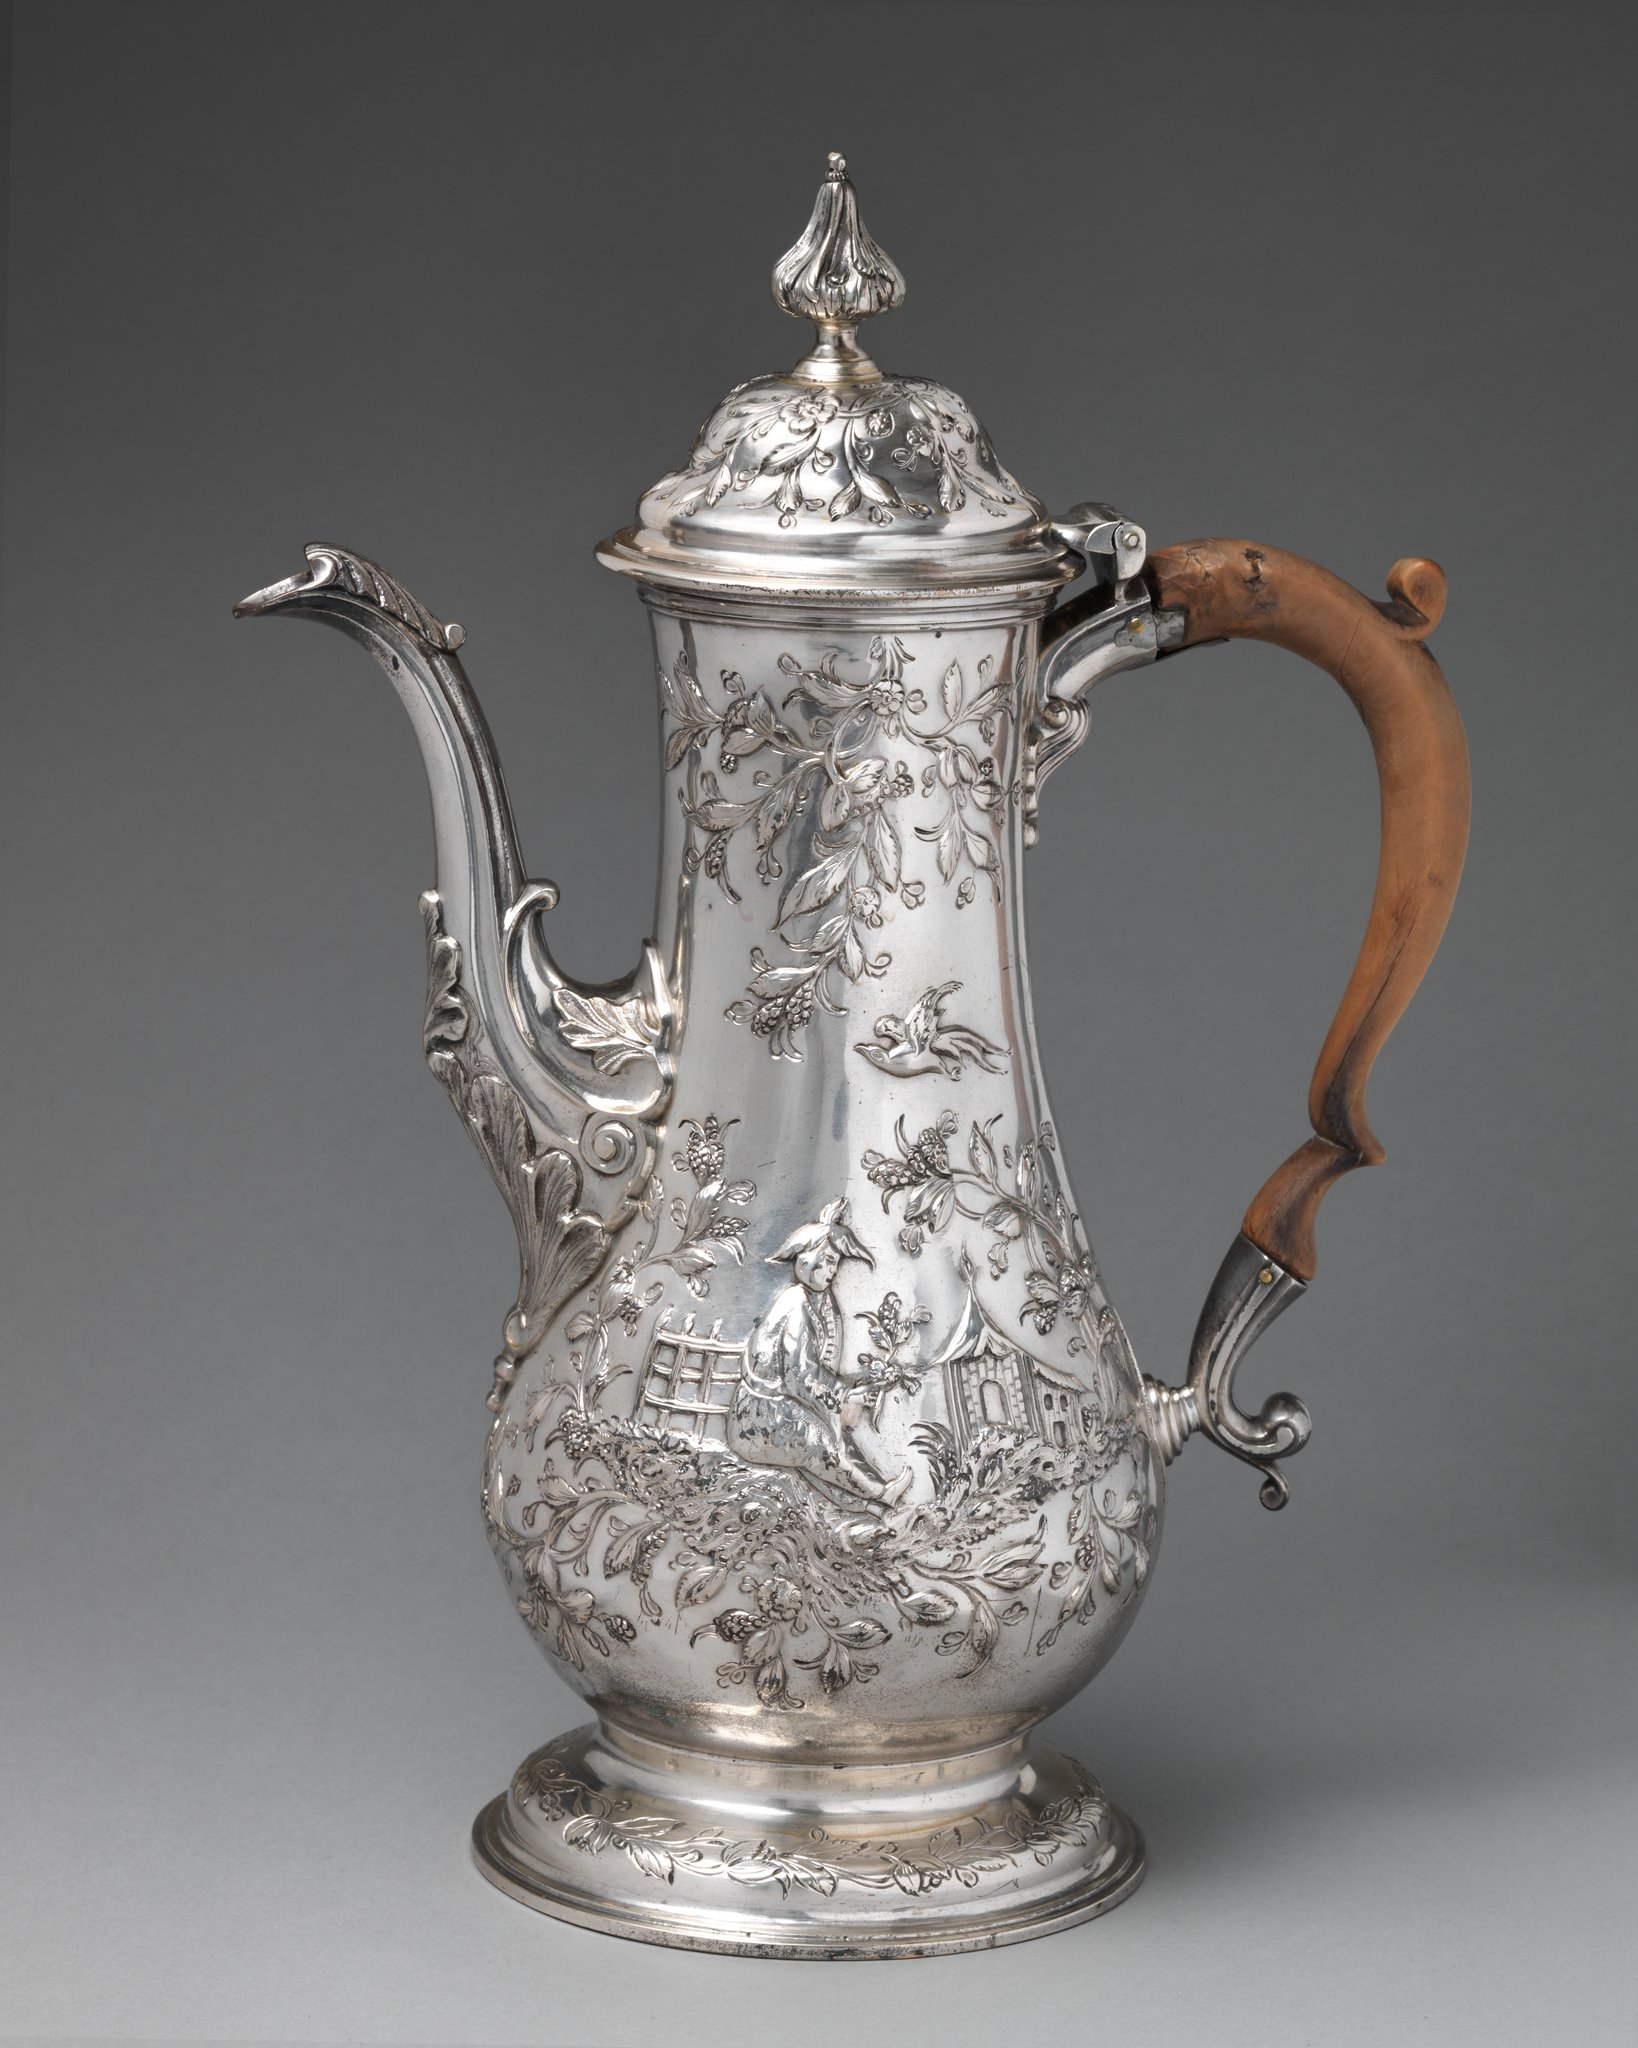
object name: coffeepot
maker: william priest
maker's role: maker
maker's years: 1711-1811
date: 1769-1770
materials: silver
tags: human figures,birds,houses